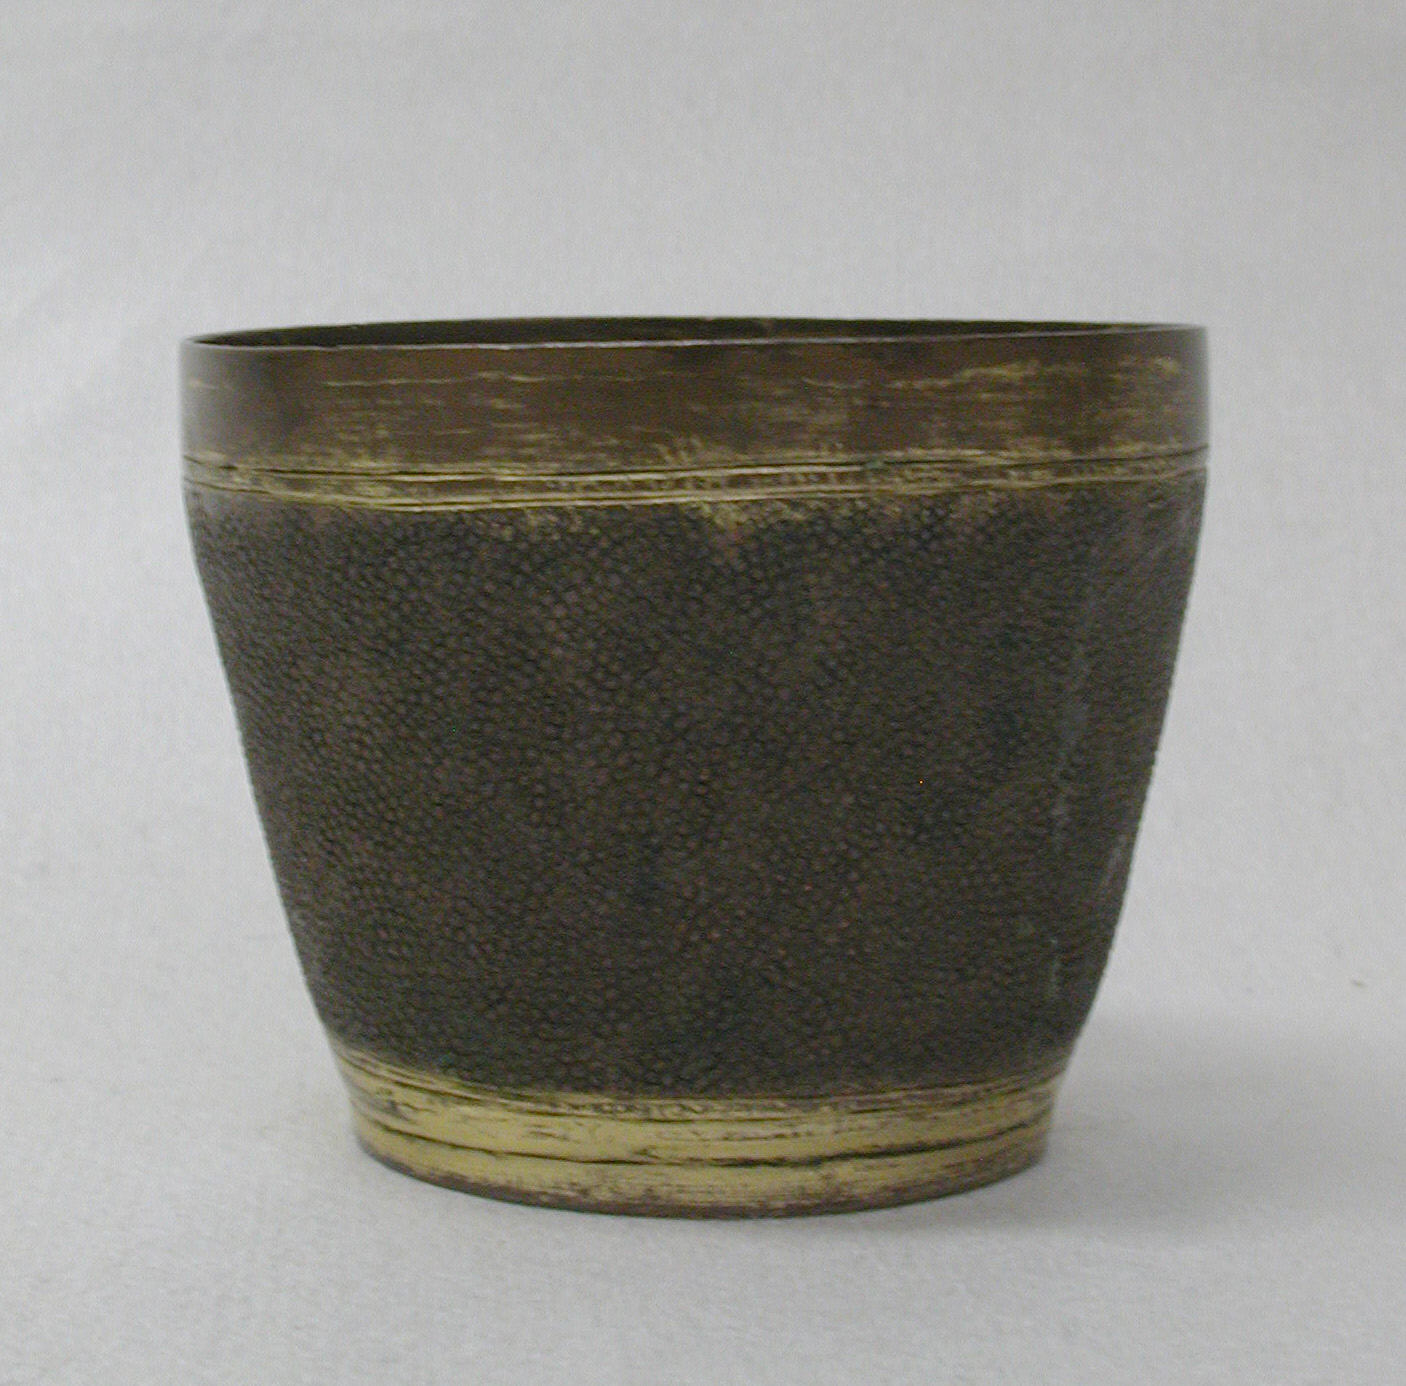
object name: cup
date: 1667-1733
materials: copper gilt